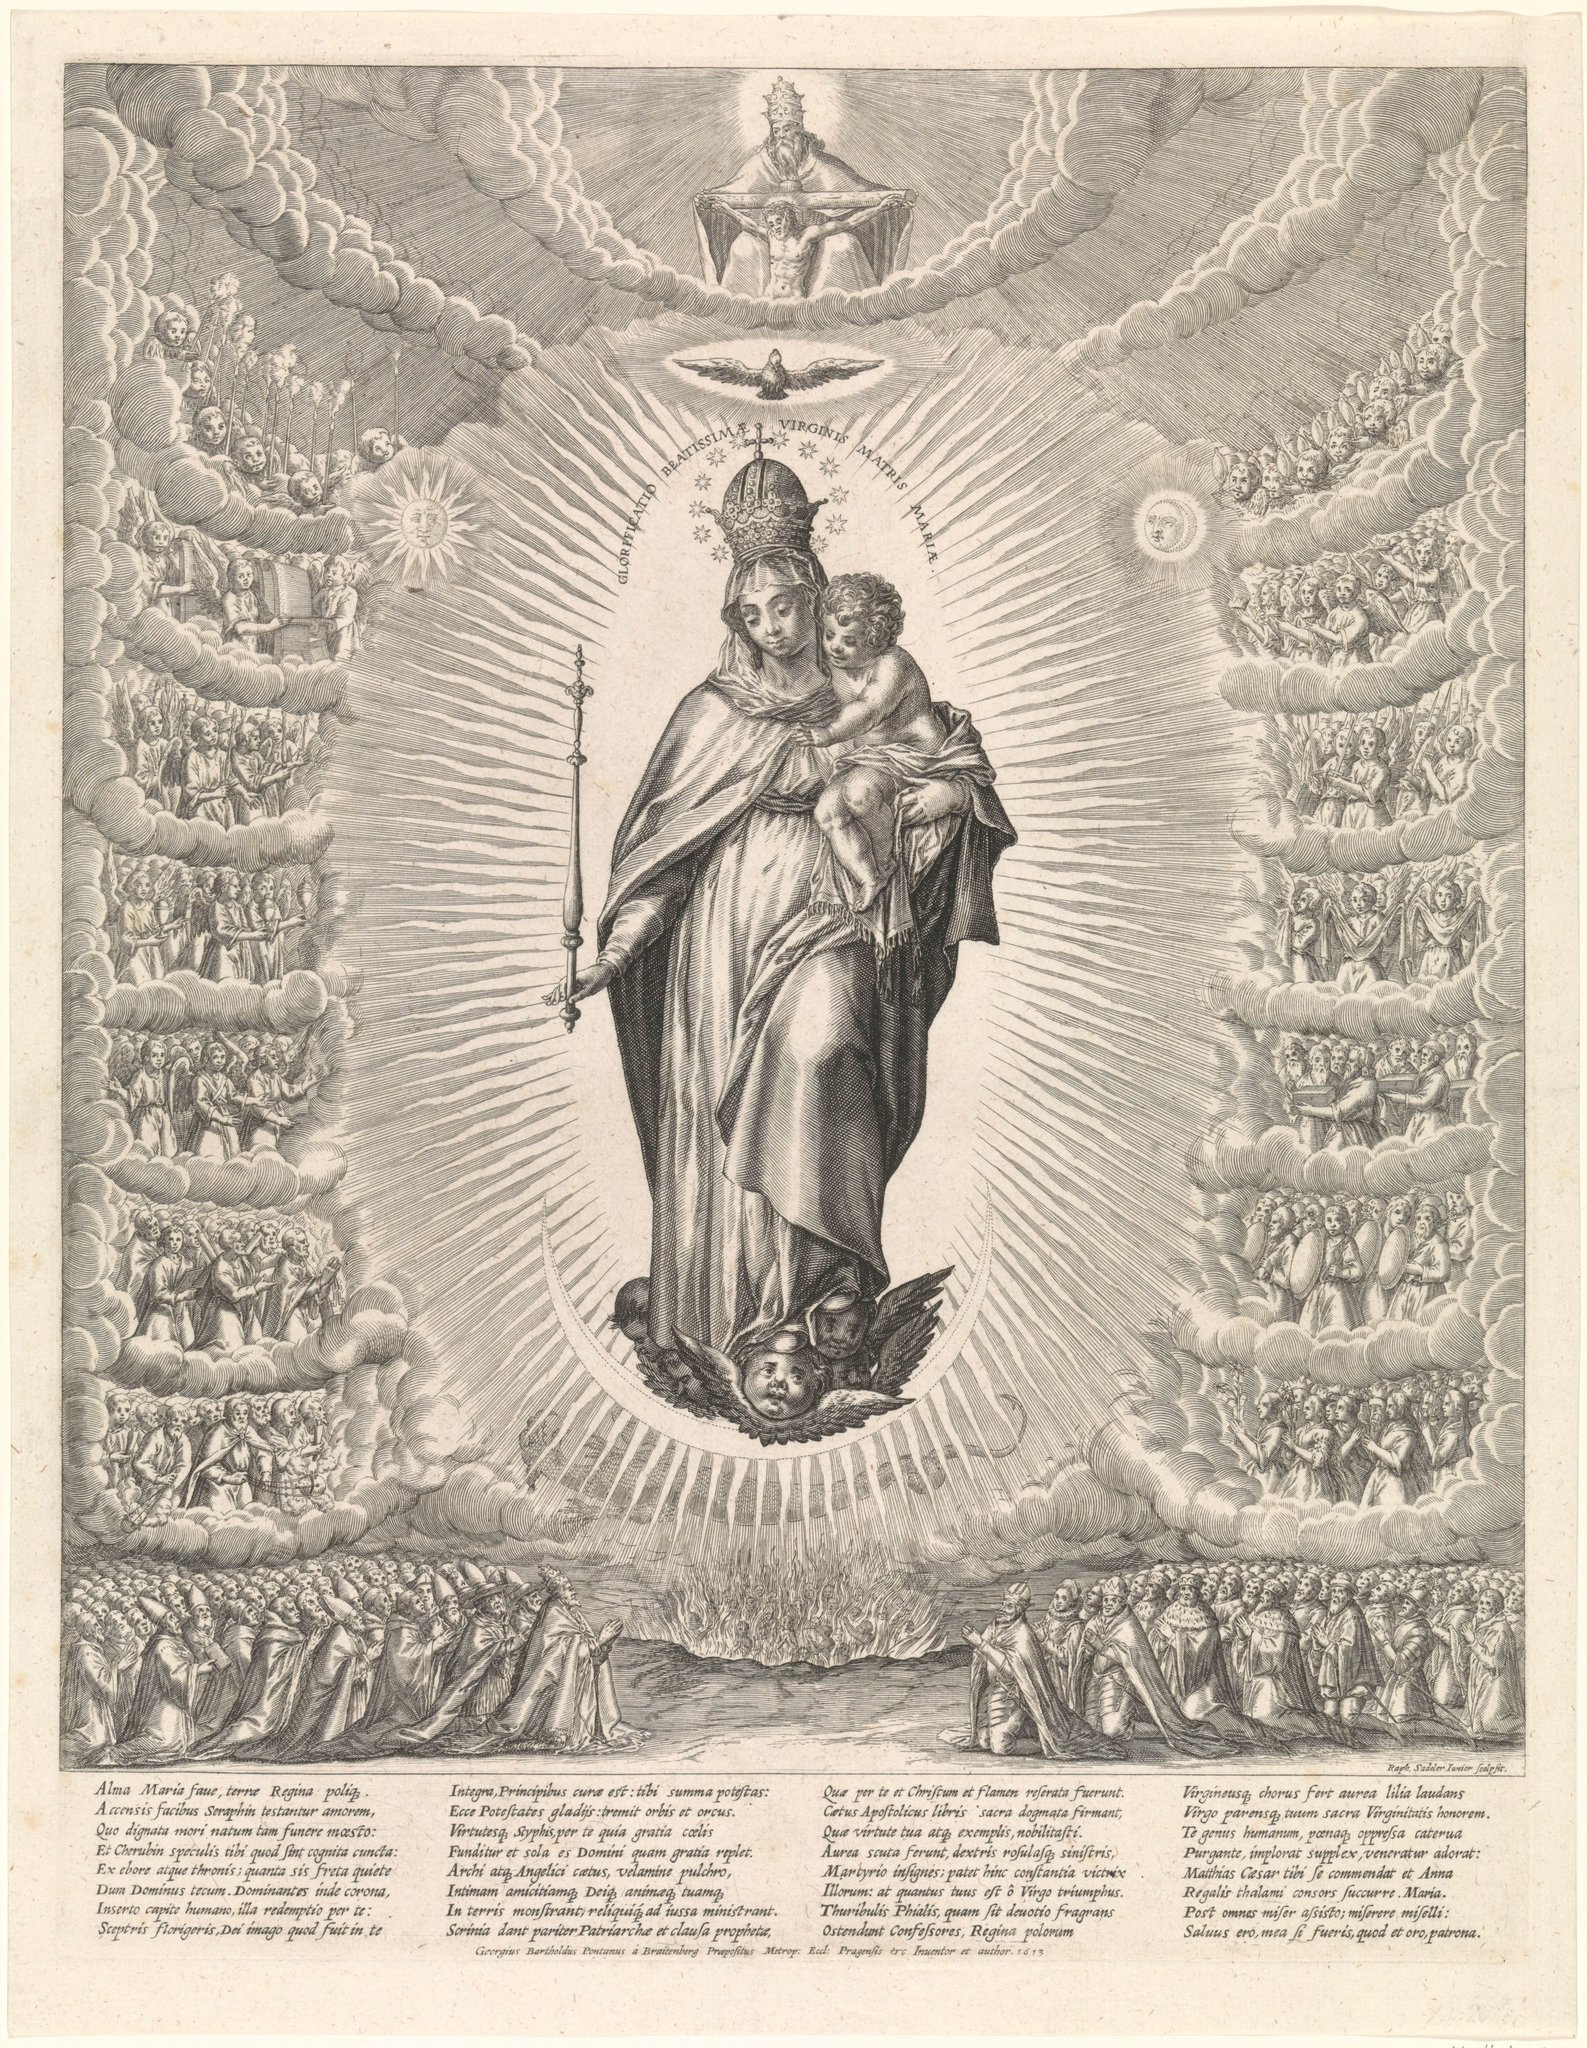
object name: print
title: Verheerlijking van de Maagd Maria met het Christuskind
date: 1613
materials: paper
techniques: engraving, etching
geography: munich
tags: madonna on the crescent of the moon (sometimes called queen of heaven) (in mandorla) (+ holy trinity), hierarchy of jurisdiction ~ roman catholic church, representations of hell (with the damned and devils), usually with burning fires, madonna (i.e. mary with the christ-child) in the air, or on the clouds, god the father as bearded old man, usually with crown or tiara or sceptre and/or globe, all saints, 'all who are redeemed and now in heaven', ruler, sovereign, the nine choirs of angels, hierarchy of angels, god the father holding the crucified or dead christ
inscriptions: collector's mark: Lugt 2760, collector's mark: Lugt 2228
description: De maagd Maria staat op de maansikkel met het Christuskind in haar arm. Onder de maansikkel een draak. Maria draagt een kroon met sterren en heeft een scepter in de hand. Boven haar de Heilige Geest als duif met links de zon en rechts de maan. Centraal bovenaan God de vader met de gekruisigde Christus. Rondom Maria engelen, apostelen, martelaren en heiligen. Onderaan de prent rechts de geestelijke macht met de paus, de kardinalen en de bisschoppen. Links de wereldlijke macht met de keizer, de koningen en soevereinen. In het midden onderaan het hellevuur. De prent heeft een Latijns onderschrift.